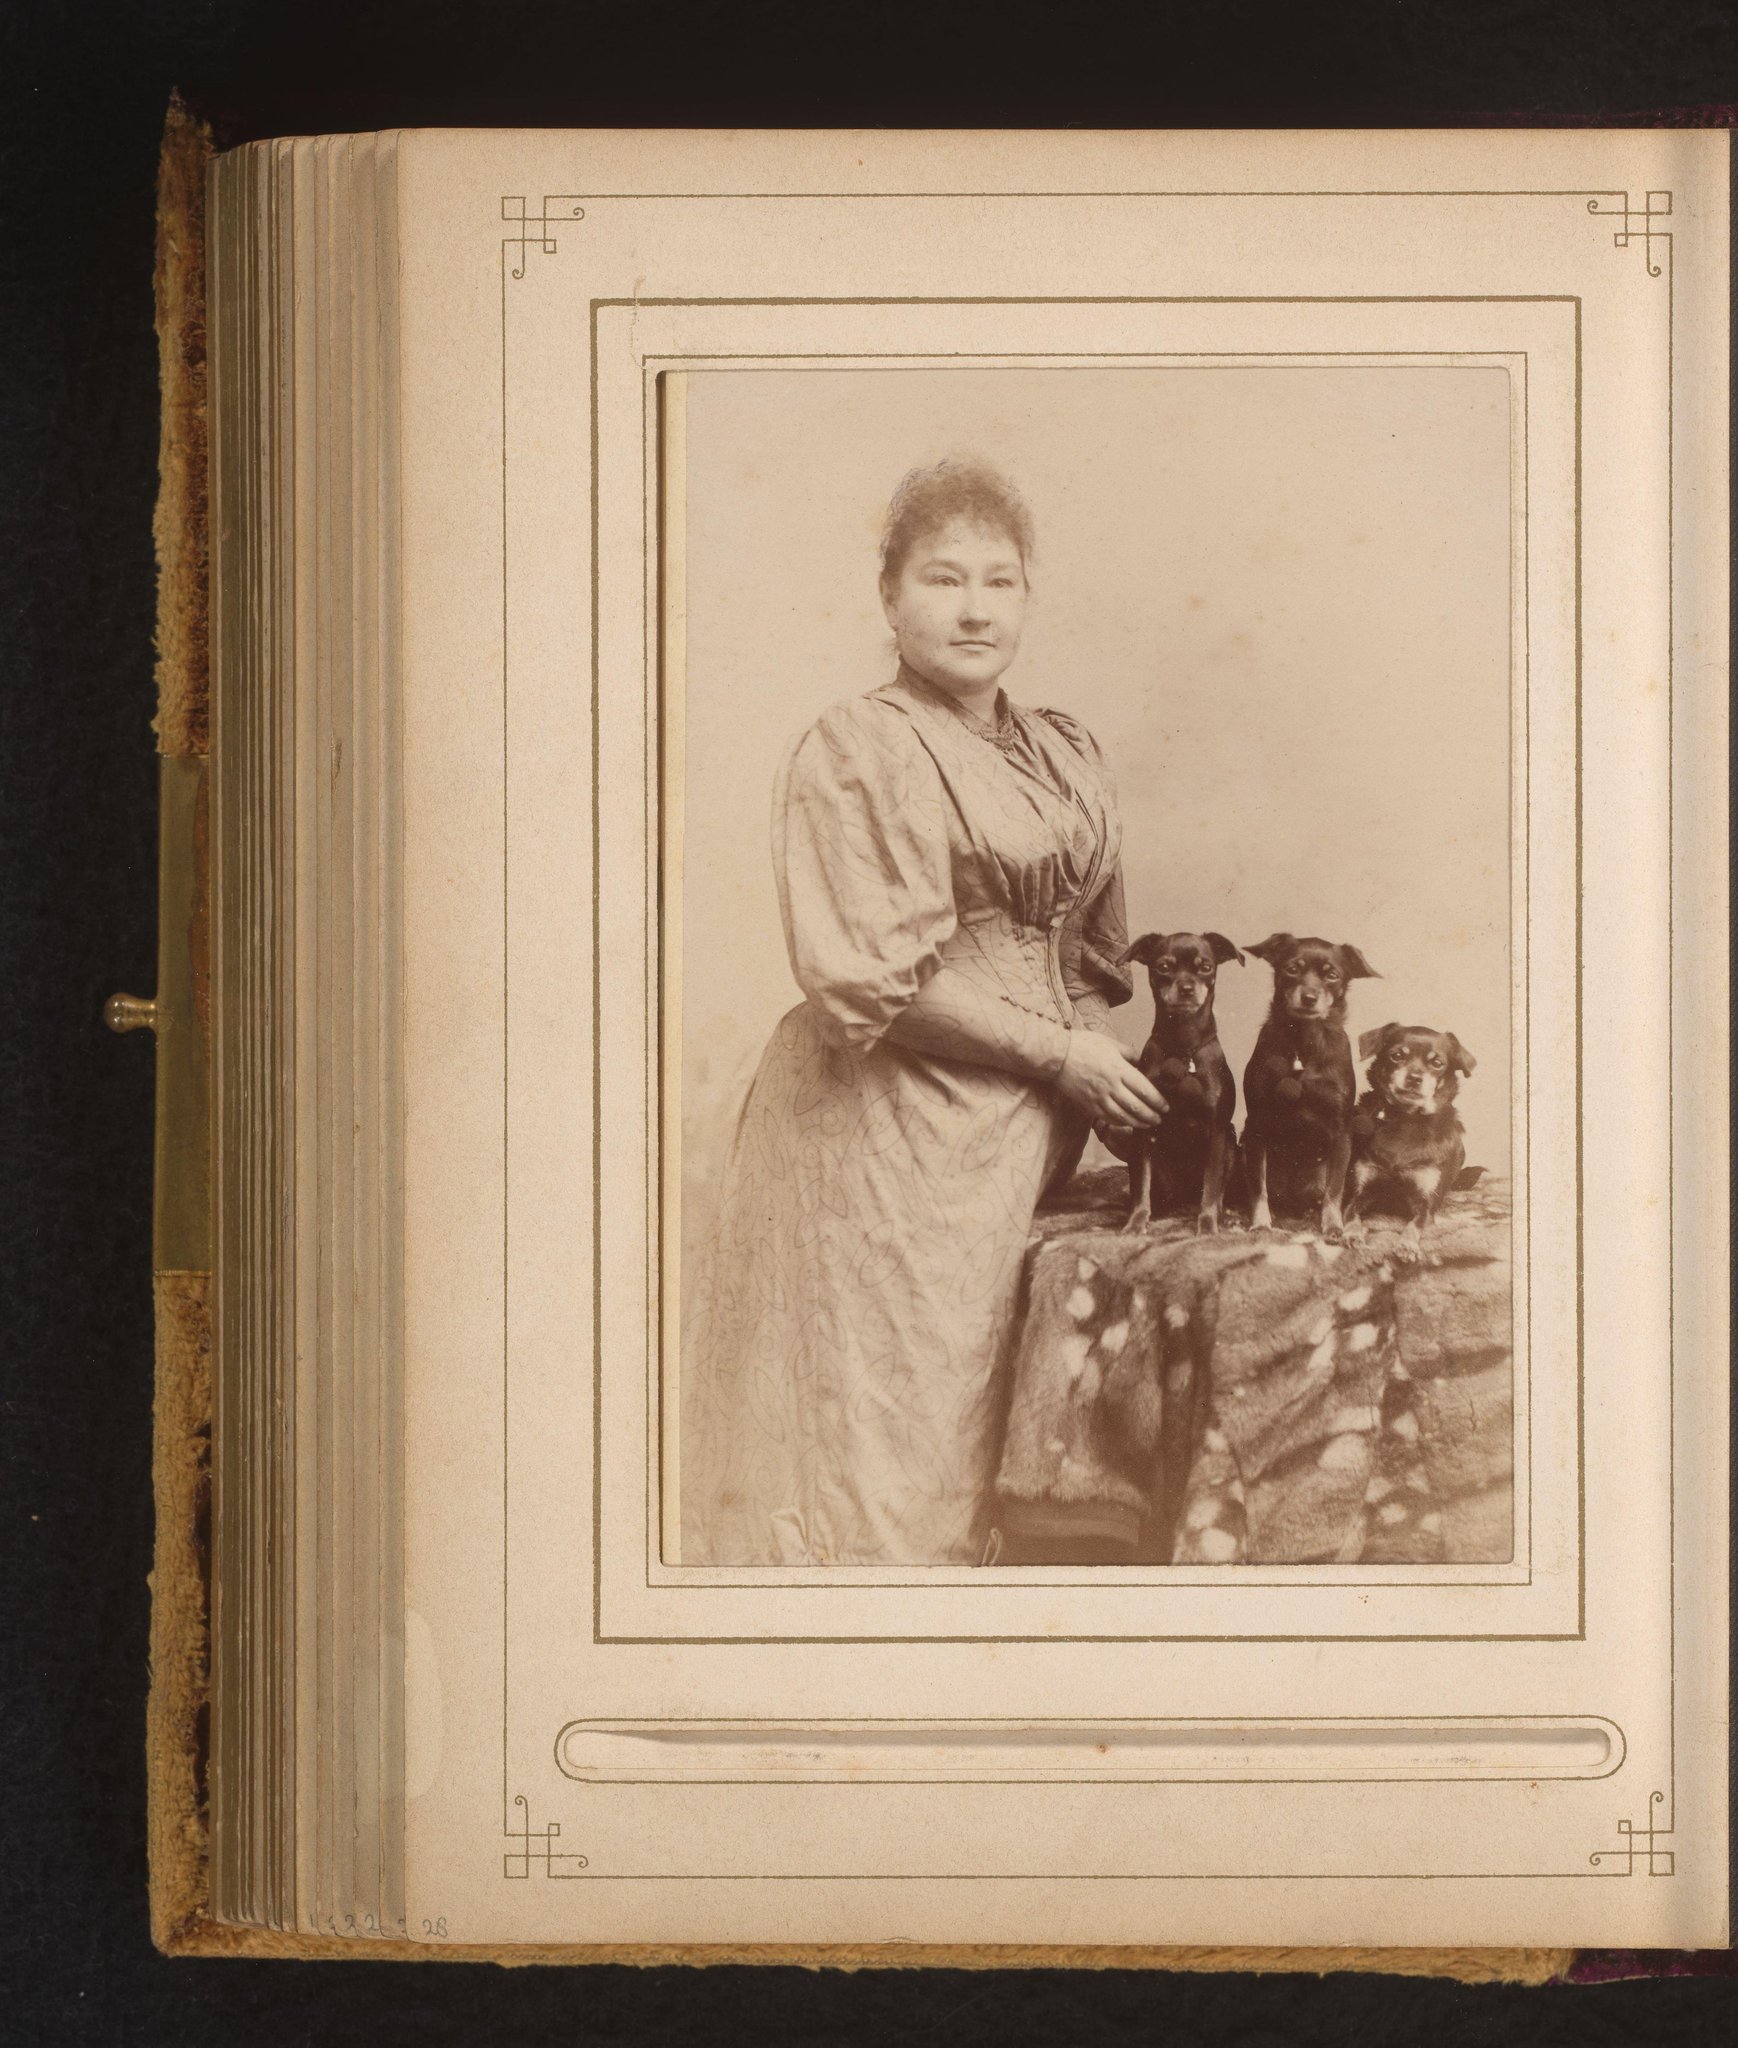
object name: cabinet photograph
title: Portret van een vrouw, staand bij een tafel met drie kleine honden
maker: adrianus van der grient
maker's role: fotograaf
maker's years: 1858-1941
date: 1888-1907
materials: cardboard, photographic support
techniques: albumen print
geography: the hague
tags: historical persons - bb - woman, standing figure - aa - female human figure, dog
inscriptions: inscription: ‘A. van der Grient/ PHOTOGRAPIE INSTANTANÉE/ den Haag Jacob v.d. Doesstraat No.8, by de Piet Heinstraat.’